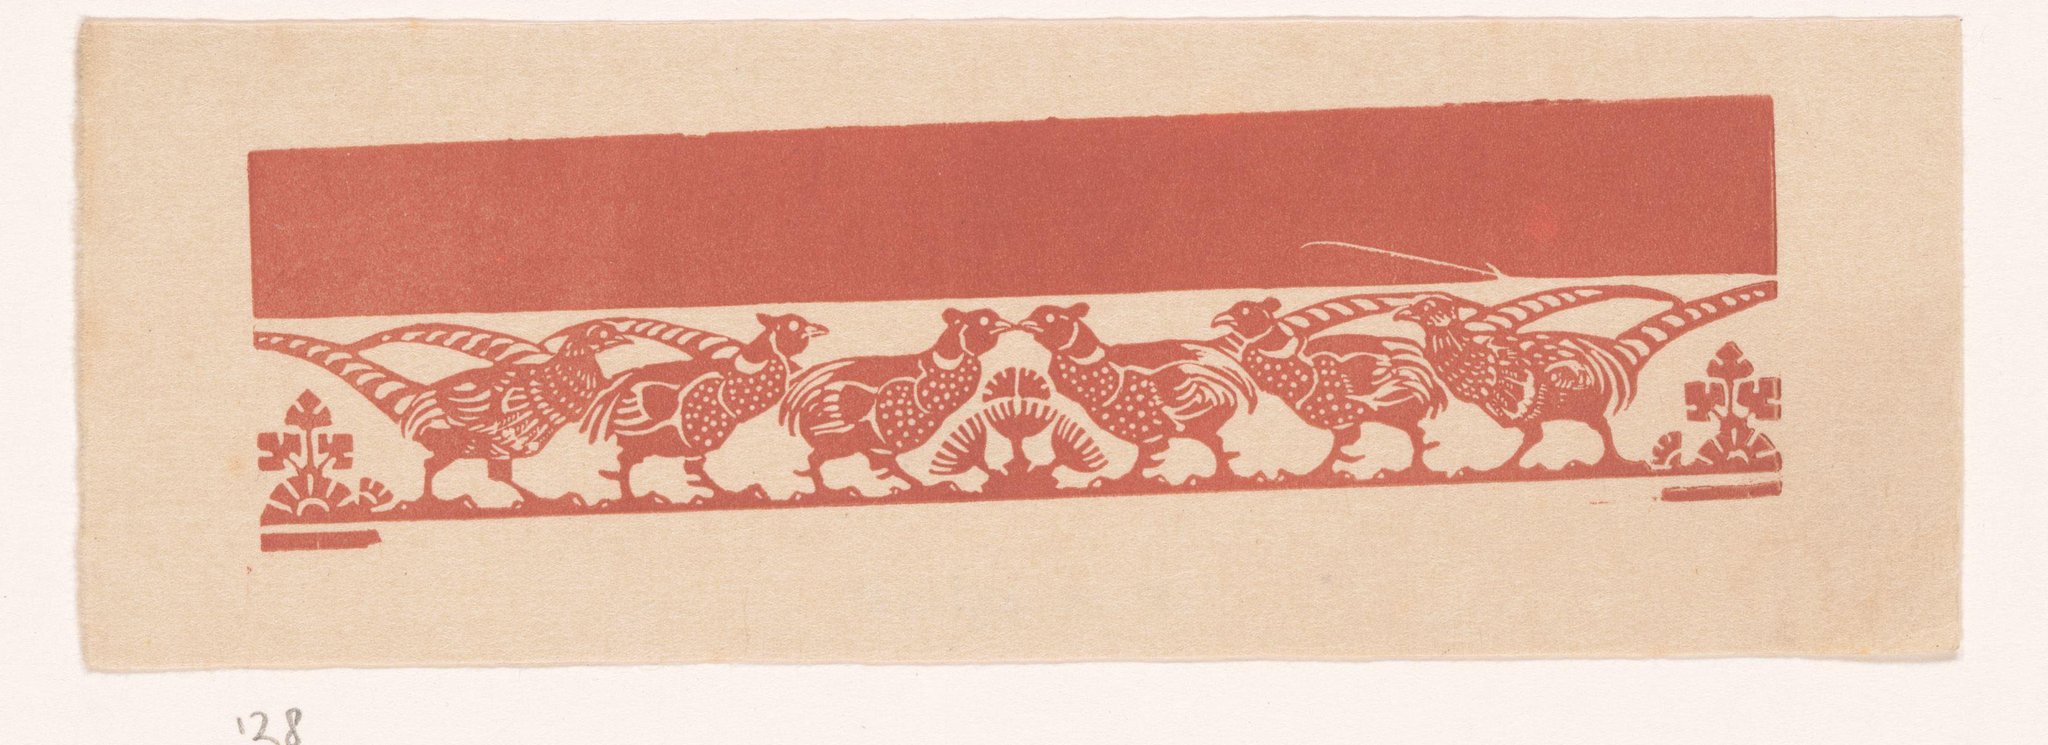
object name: boekillustratie ontwerp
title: Ornamentele rand met fazanten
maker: bernard willem wierink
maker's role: draughtsman, print maker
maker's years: 1856-1939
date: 1910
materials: paper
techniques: relief print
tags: walker and runner birds: pheasant, fable of reynard the fox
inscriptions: collector's mark: Lugt 2228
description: Ontwerp voor: Streuvels, Stijn (Frank Lateur). Reinaert de Vos naar verschillende uitgaven van het middeleeuwsche epos. Amsterdam: L.J. Veen, 1910. Deze prent is vermoedelijk een plaatsnede, ook al wordt in de literatuur veelal gesproken over een houtsnede. Voor zover Wierink zijn prenten in hoogdruk zelf nader heeft omschreven, heeft hij altijd de term 'plaatsnede' gebruikt.